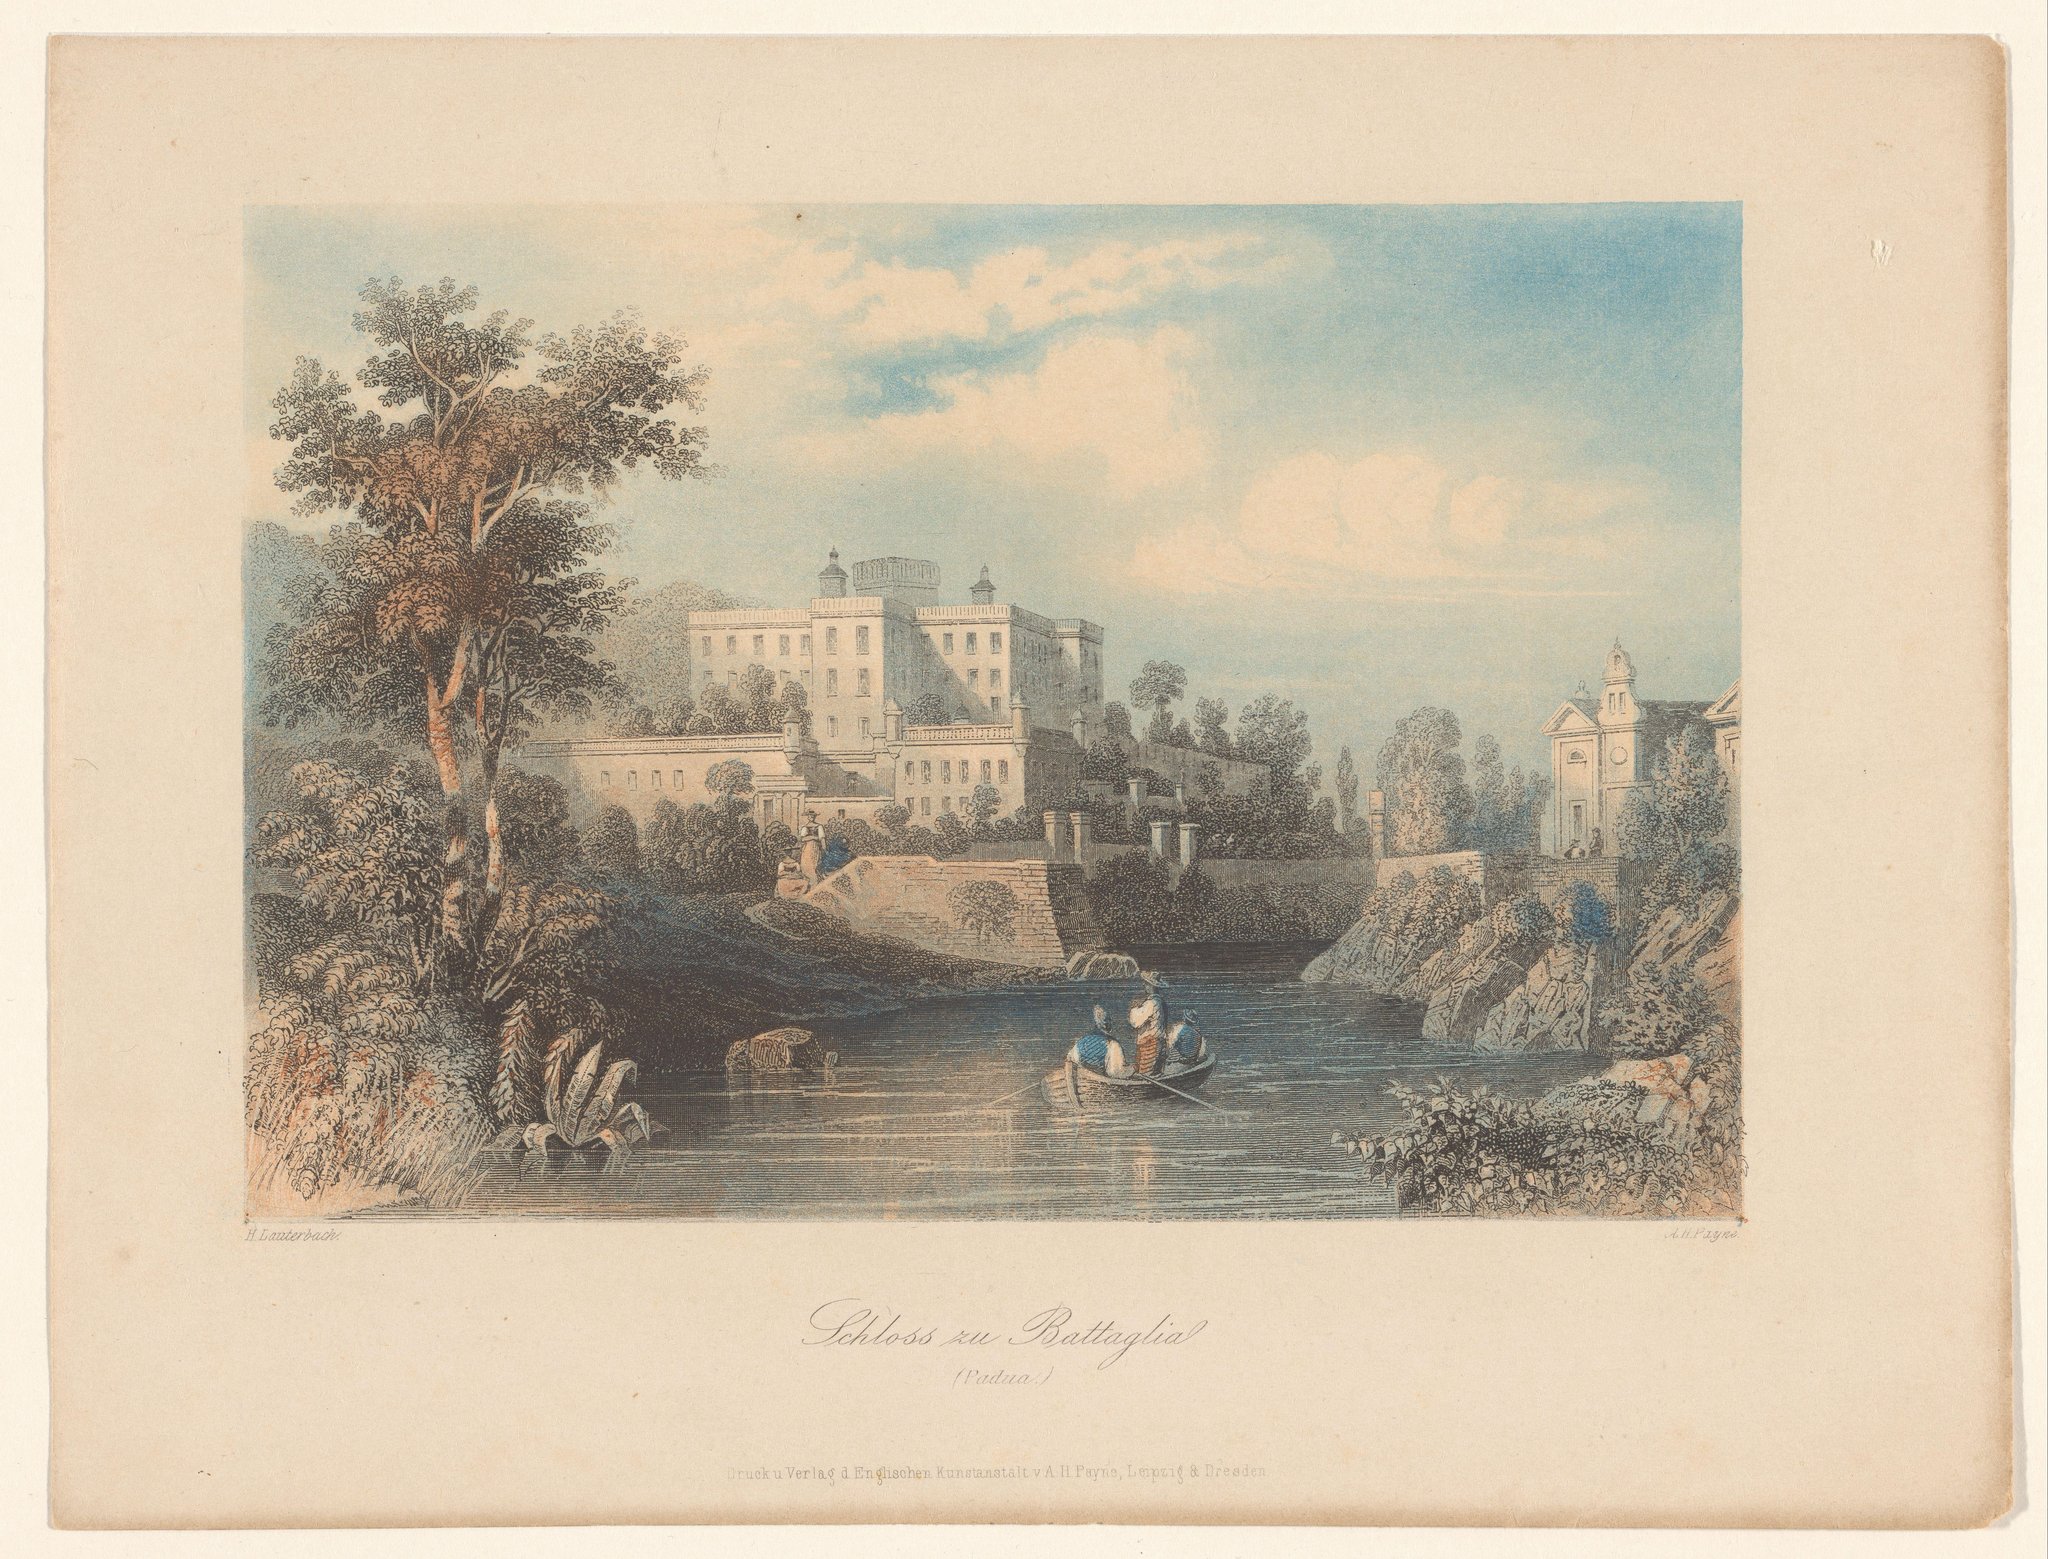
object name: print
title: Schloss zu Battaglia (Padua)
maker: albert henry payne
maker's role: print maker, publisher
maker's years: 1812-1902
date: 1845-1902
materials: paper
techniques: etching, hand coloring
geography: germany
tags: castle, rowing-boat, canoe, etc.